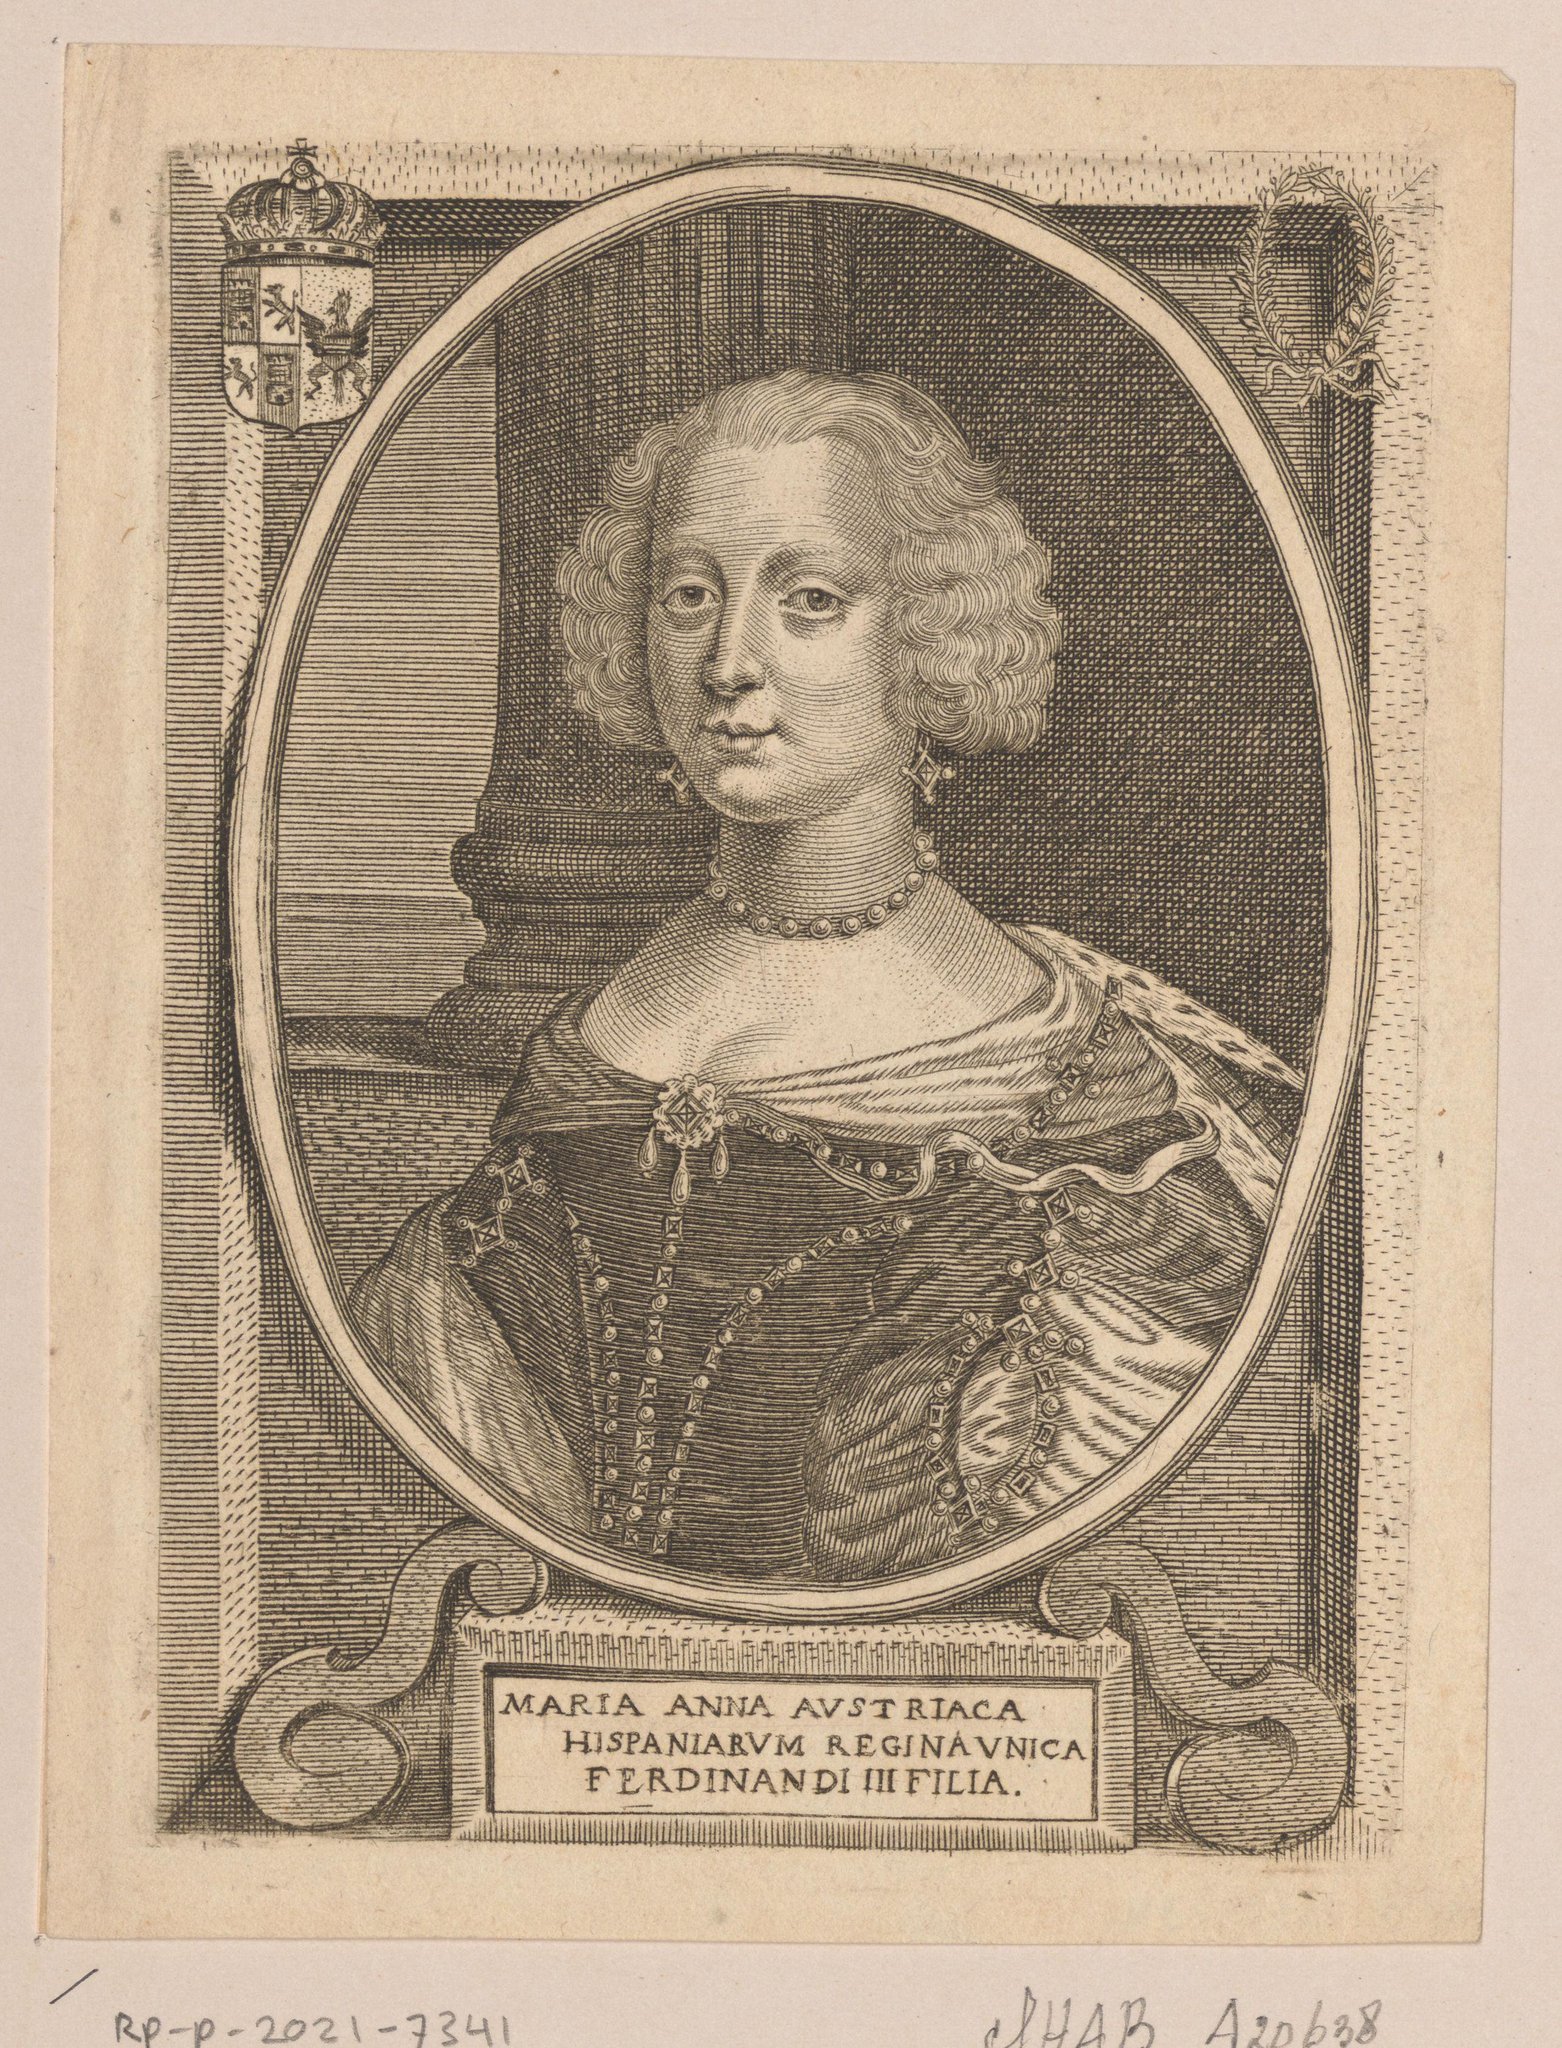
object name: print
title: Portret van Maria Anna van Oostenrijk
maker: Anonymous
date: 1649-1699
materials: paper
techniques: engraving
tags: vienna, maria anna van oostenrijk (koningin van spanje), historical persons - bb - woman, ornament ~ medallion, armorial bearing, heraldry